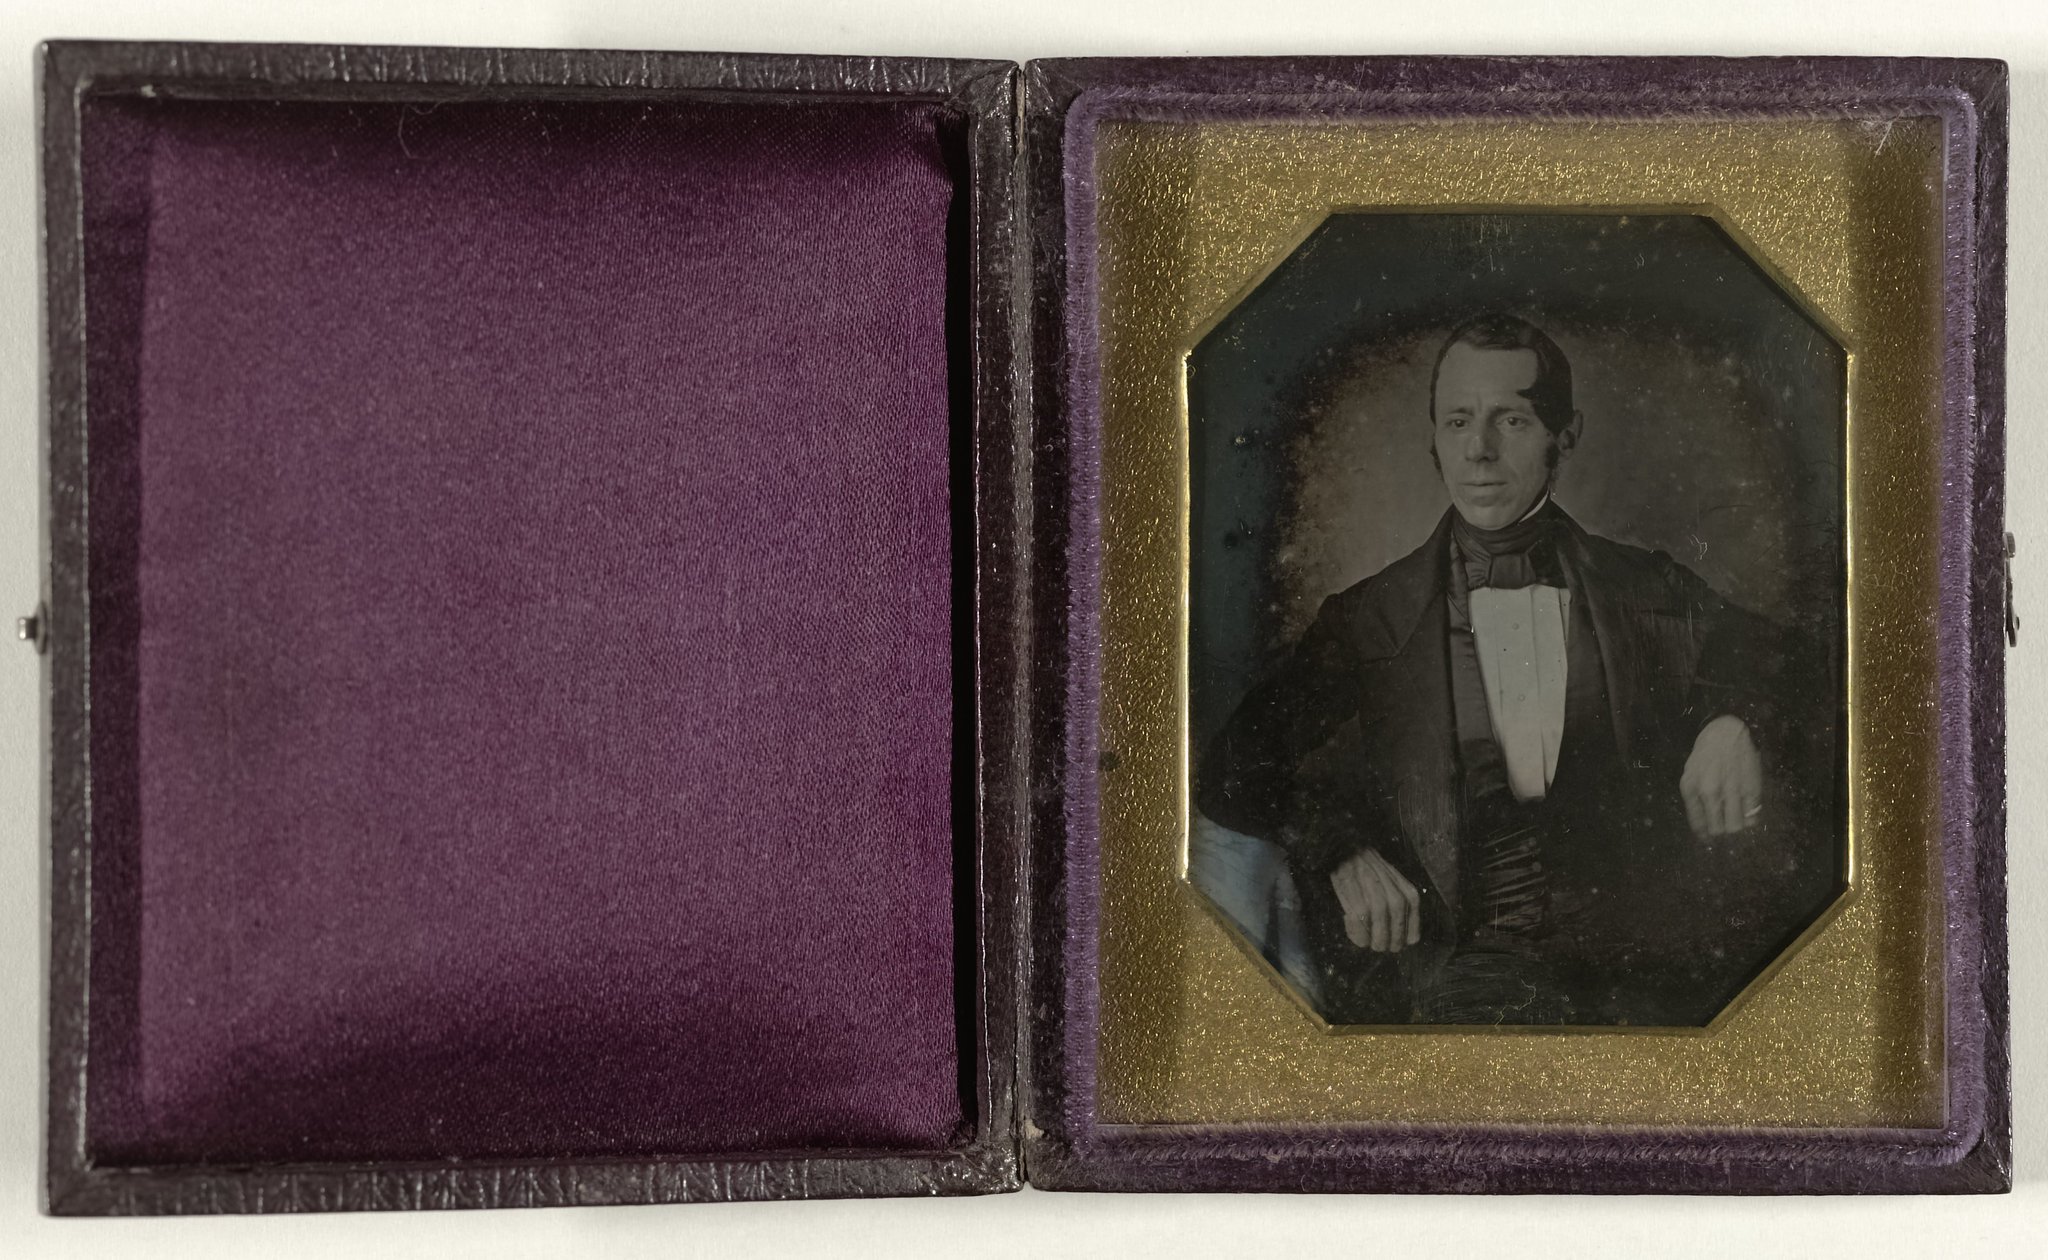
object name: photograph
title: Portret van Johannes Aegidius Lisman, waarnemend gouverneur Suriname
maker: Anonymous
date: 1849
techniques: daguerreotype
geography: paramaribo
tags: historical persons, suriname